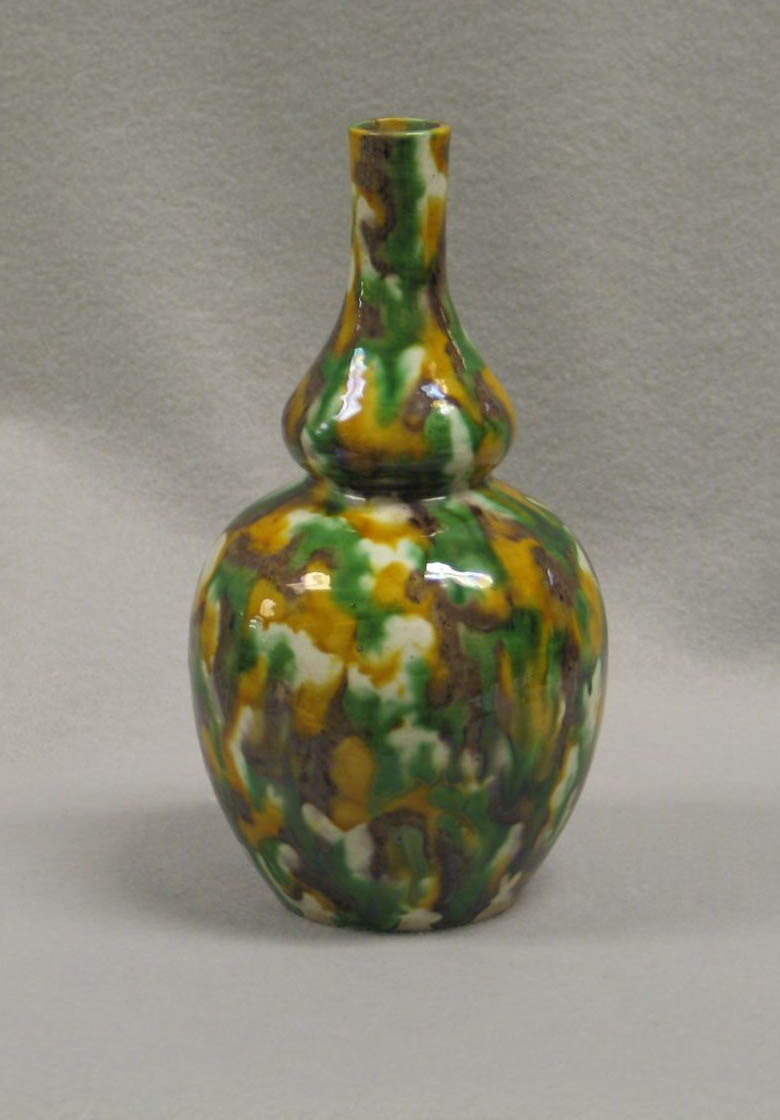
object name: vase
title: Vase in the shape of a gourd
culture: chinese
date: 1644-1911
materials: glaze, porcelain